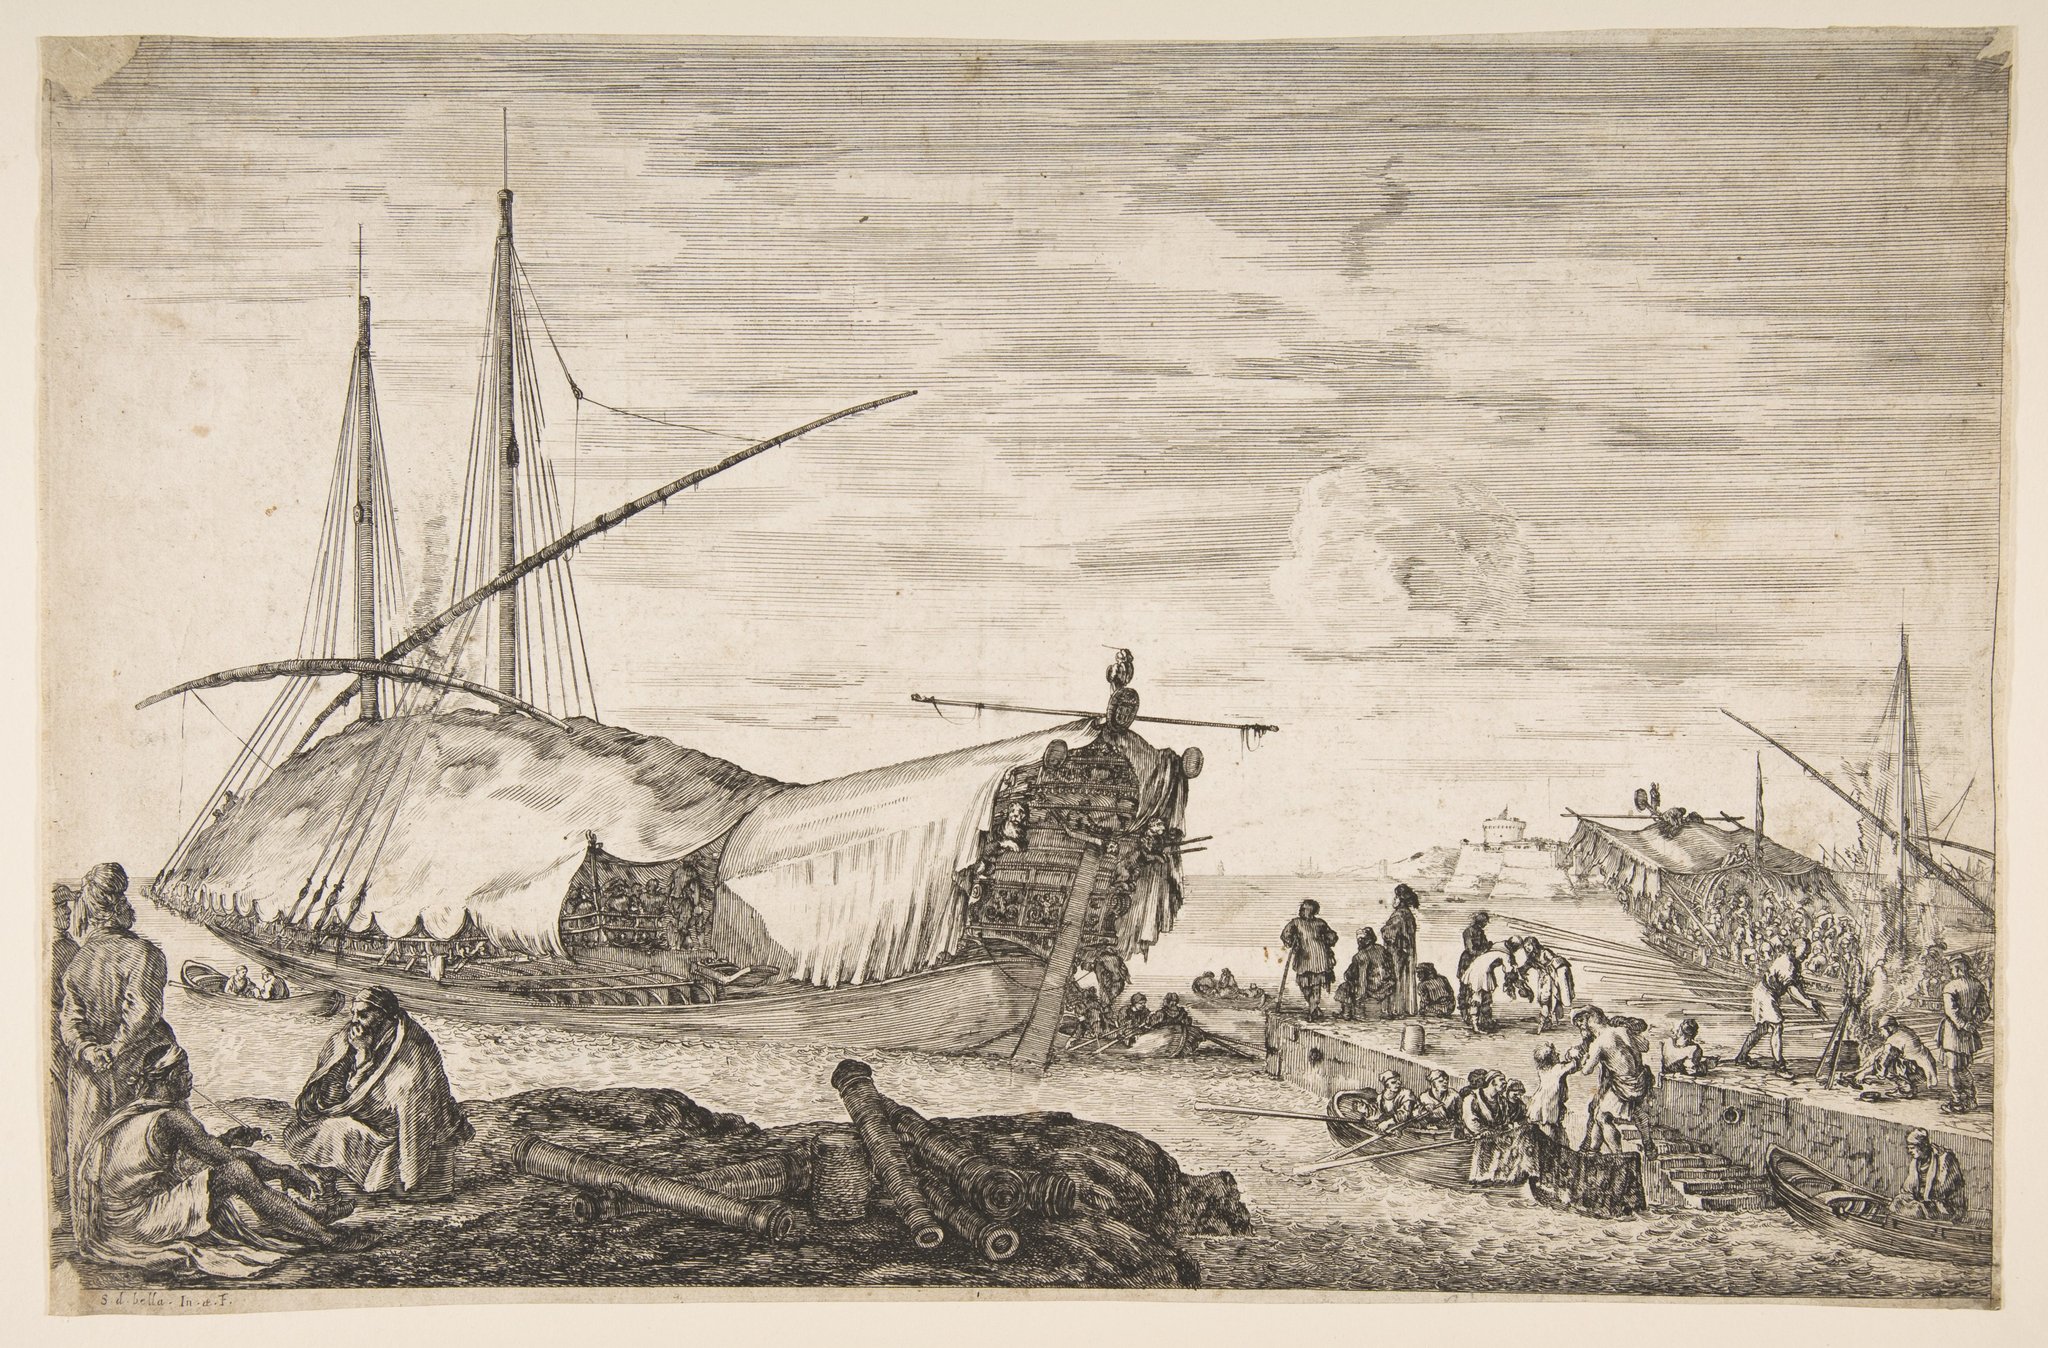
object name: print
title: A galley covered in sails to left, six cannons and four people to left in foreground, one man seated at far left smoking a pipe, a man assisting others disembarking from rowboats to right, other rowboats and ships in the background, from 'Views of the port of Livorno' (Vues du port de Livourne)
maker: stefano della bella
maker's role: artist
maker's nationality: italian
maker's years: 1610-1664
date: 1655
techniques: etching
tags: men,boats